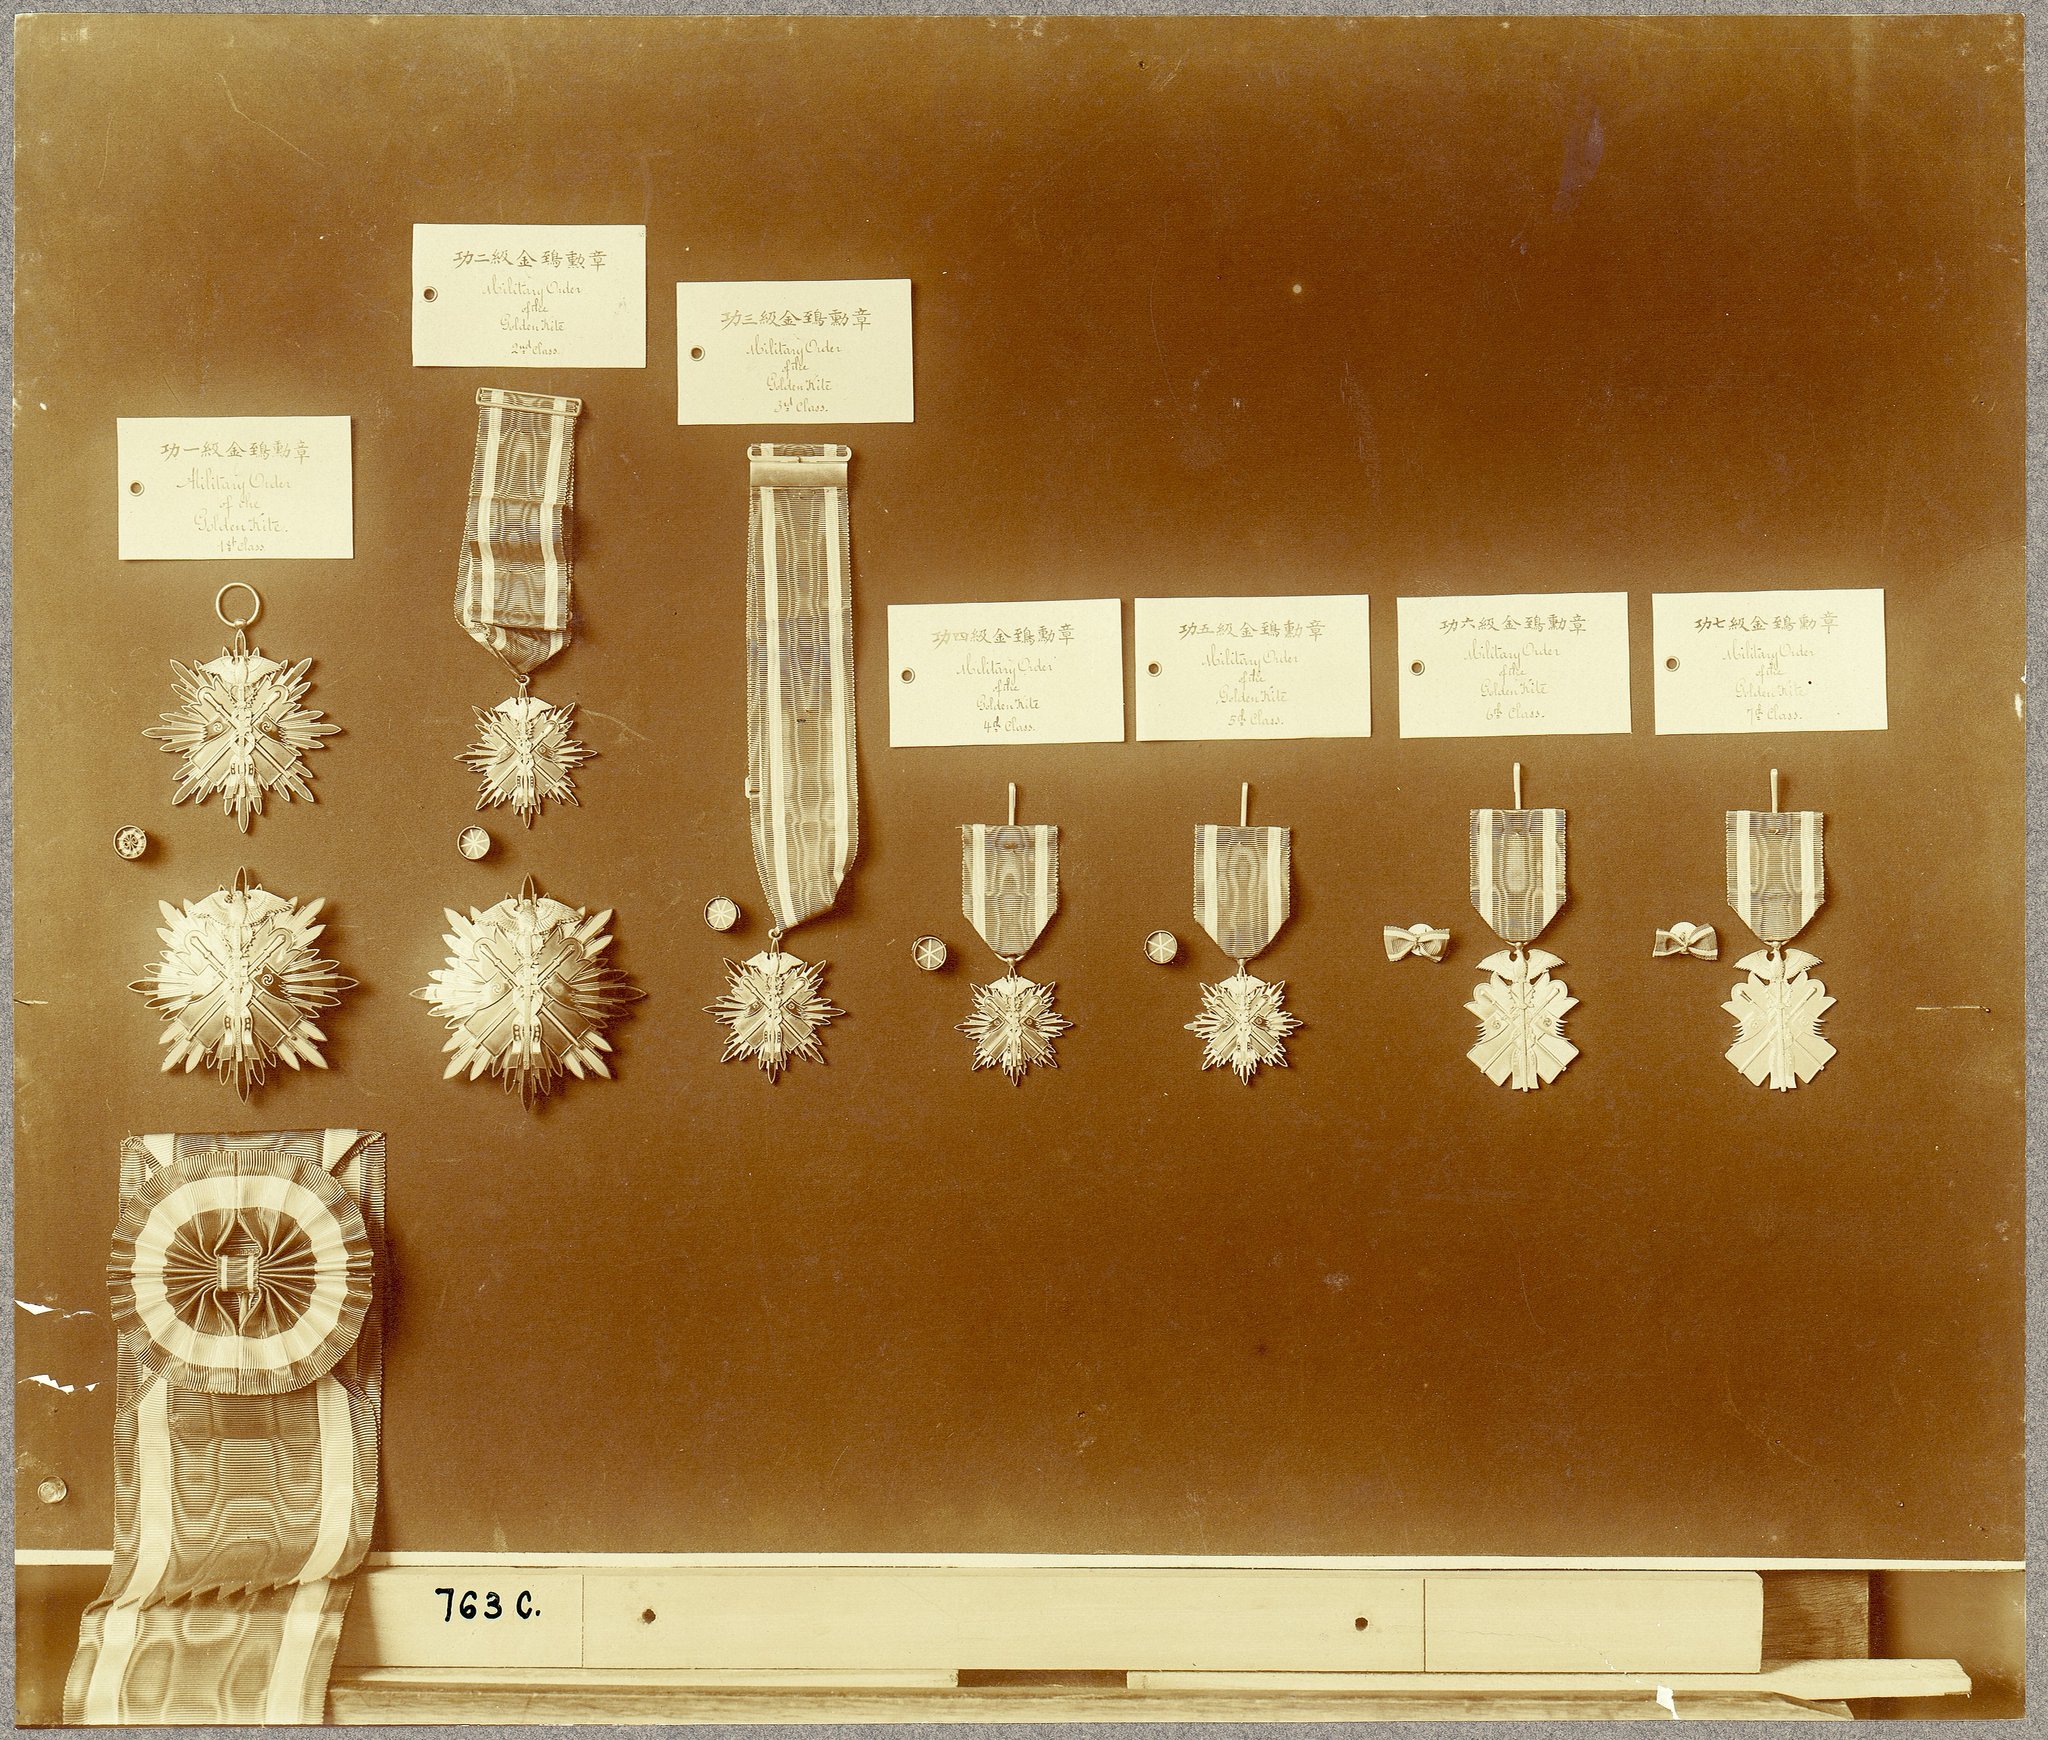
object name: photograph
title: Military Order of the Golden Kite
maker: Anonymous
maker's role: artist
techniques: albumen silver print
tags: medals